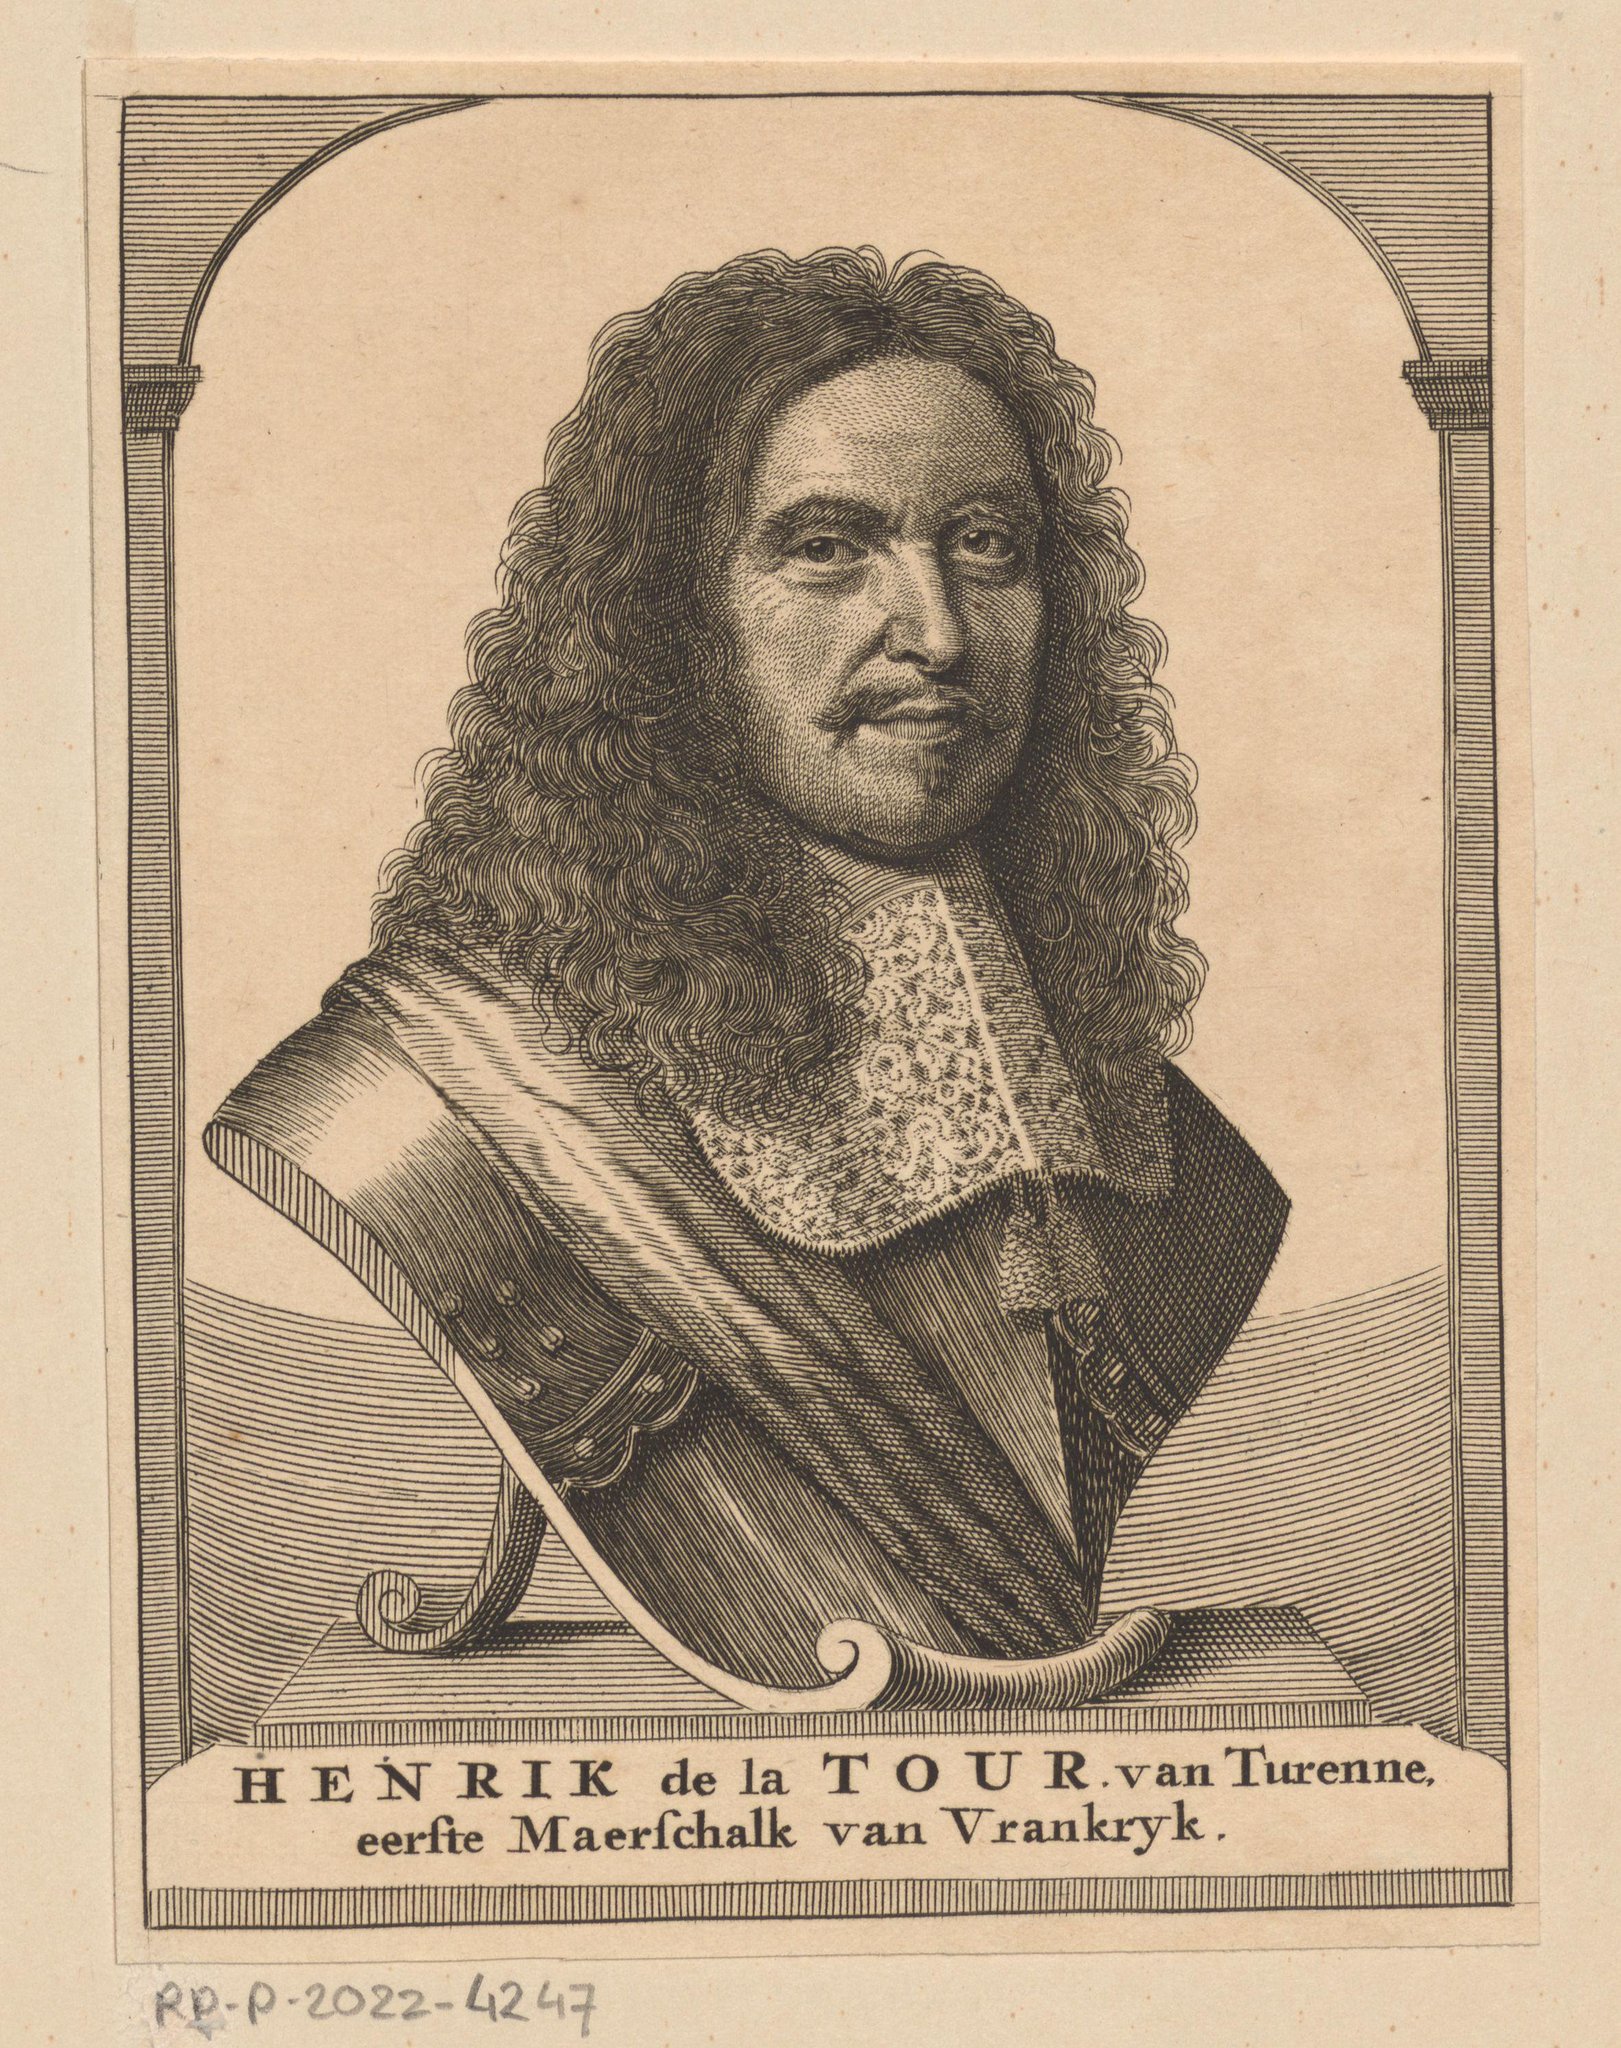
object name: print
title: Portret van Henri de La Tour d'Auvergne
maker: Anonymous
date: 1678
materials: paper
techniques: engraving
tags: commander-in-chief, general, marshal, historical persons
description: Prent waarschijnlijk uit: Brandt, Geeraert I. Tweejaerige geschiedenissen, voorgevallen in de jaeren MDCLXXIV. Amsterdam: Johannes van Someren, Abraham Wolfgangh, Hendrik en Dirk Boom, 1678.